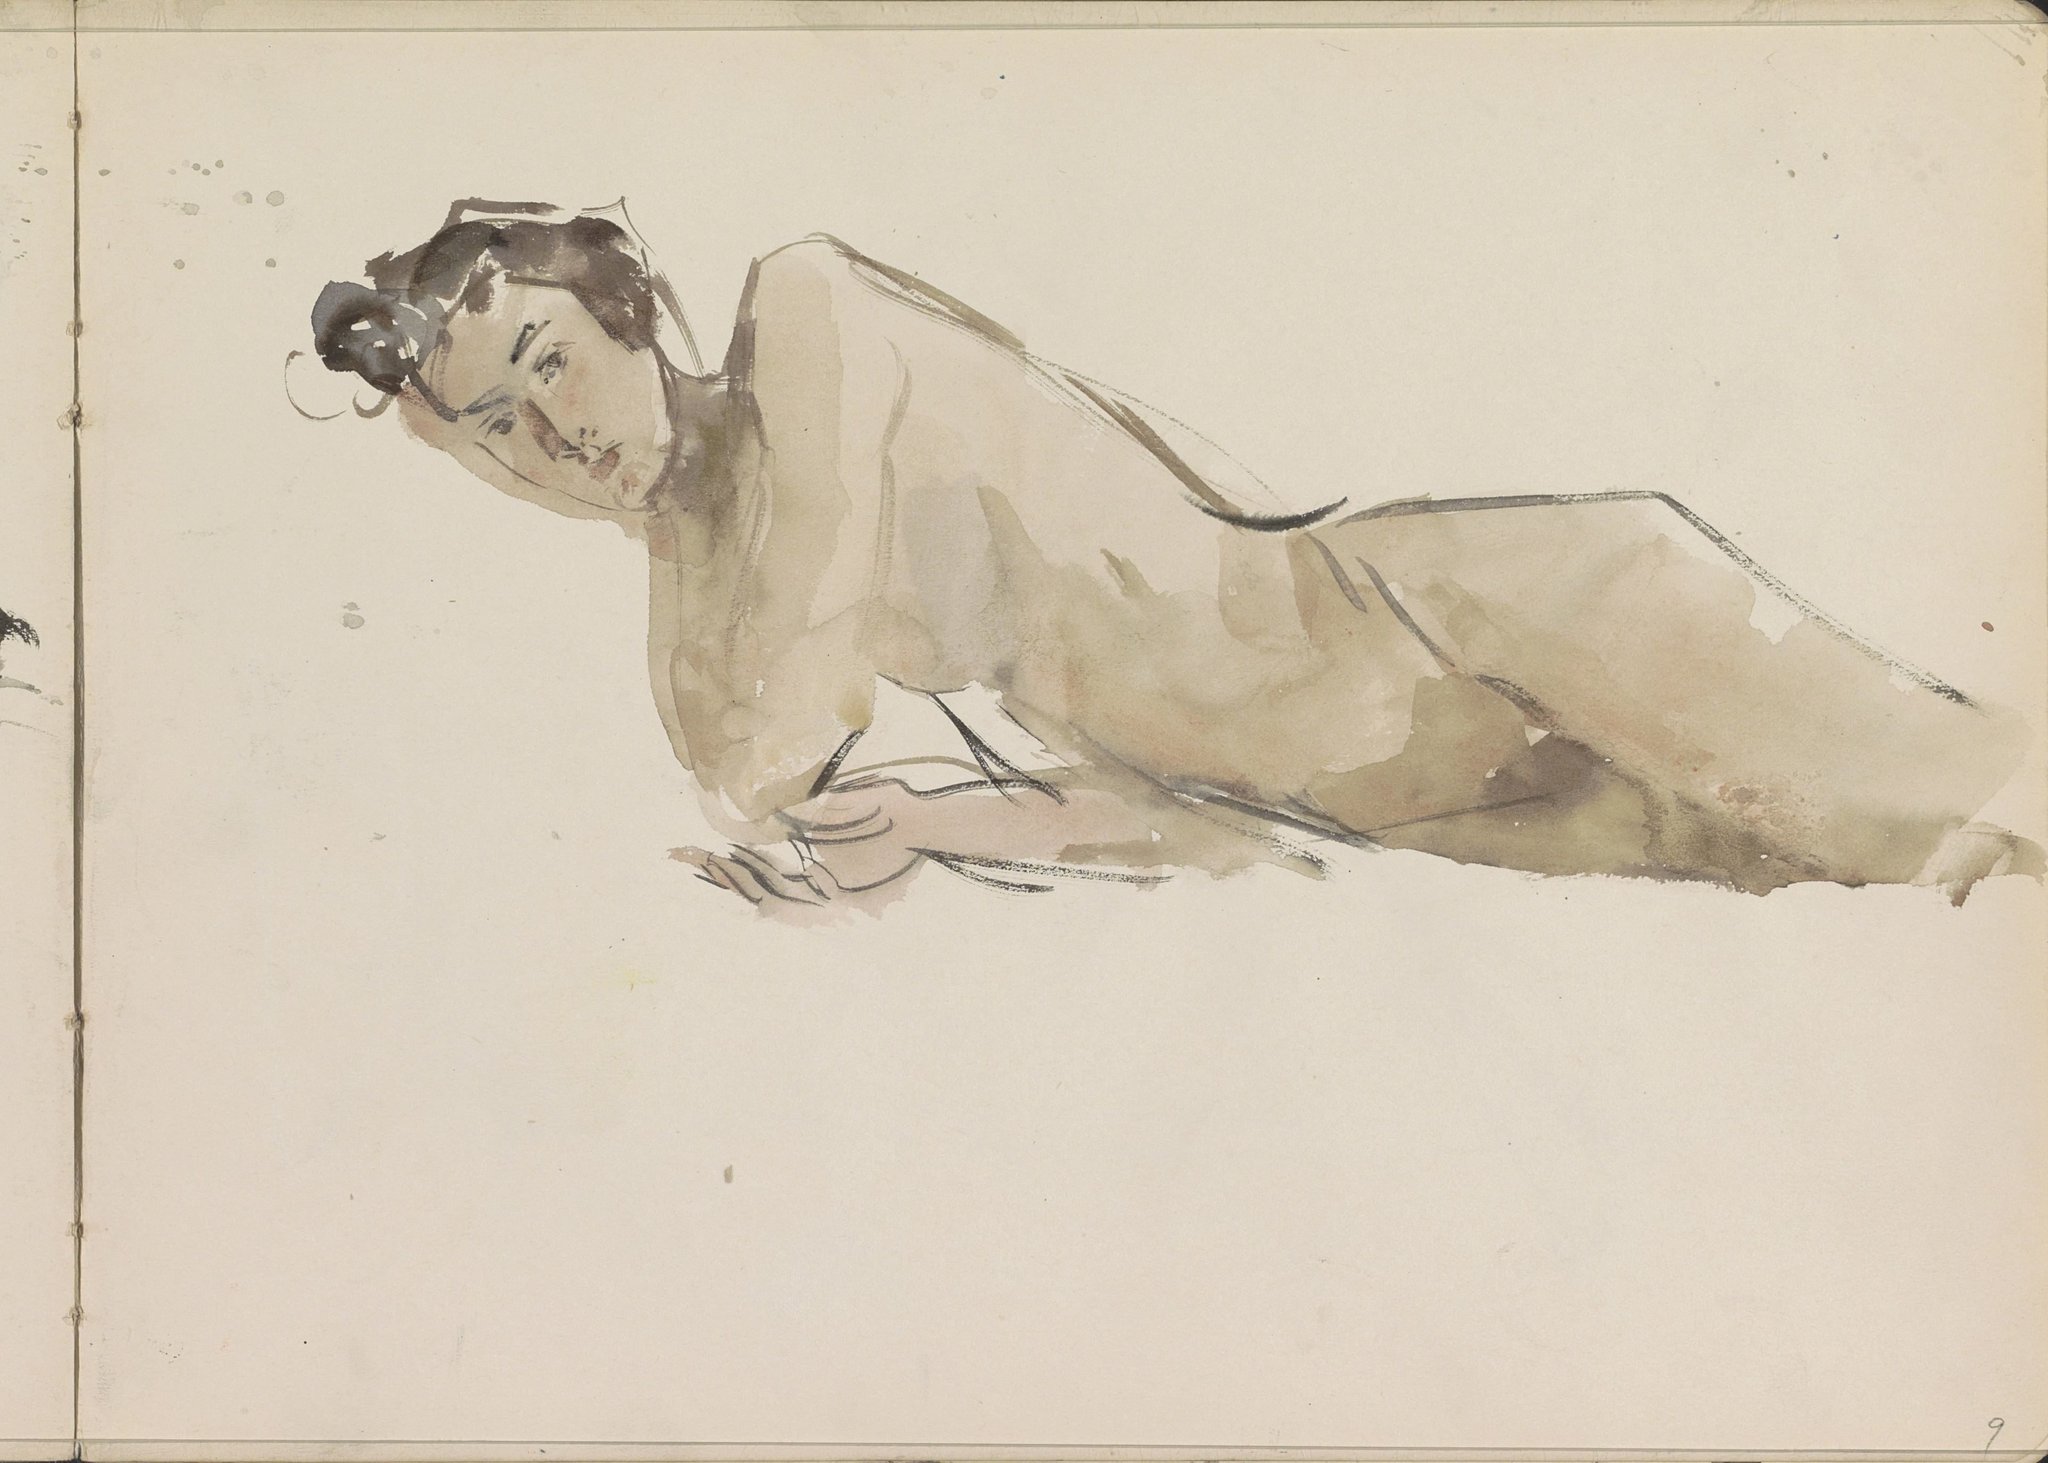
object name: sketchbook leaf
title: Standing Female Nude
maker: isaac israels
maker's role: draughtsman, painter, print maker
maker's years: 1865-1934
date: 1915-1934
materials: paper, watercolor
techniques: brush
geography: the hague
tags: standing figure - aa - female human figure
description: Blad 9 recto uit schetsboek VI met 33 bladen.